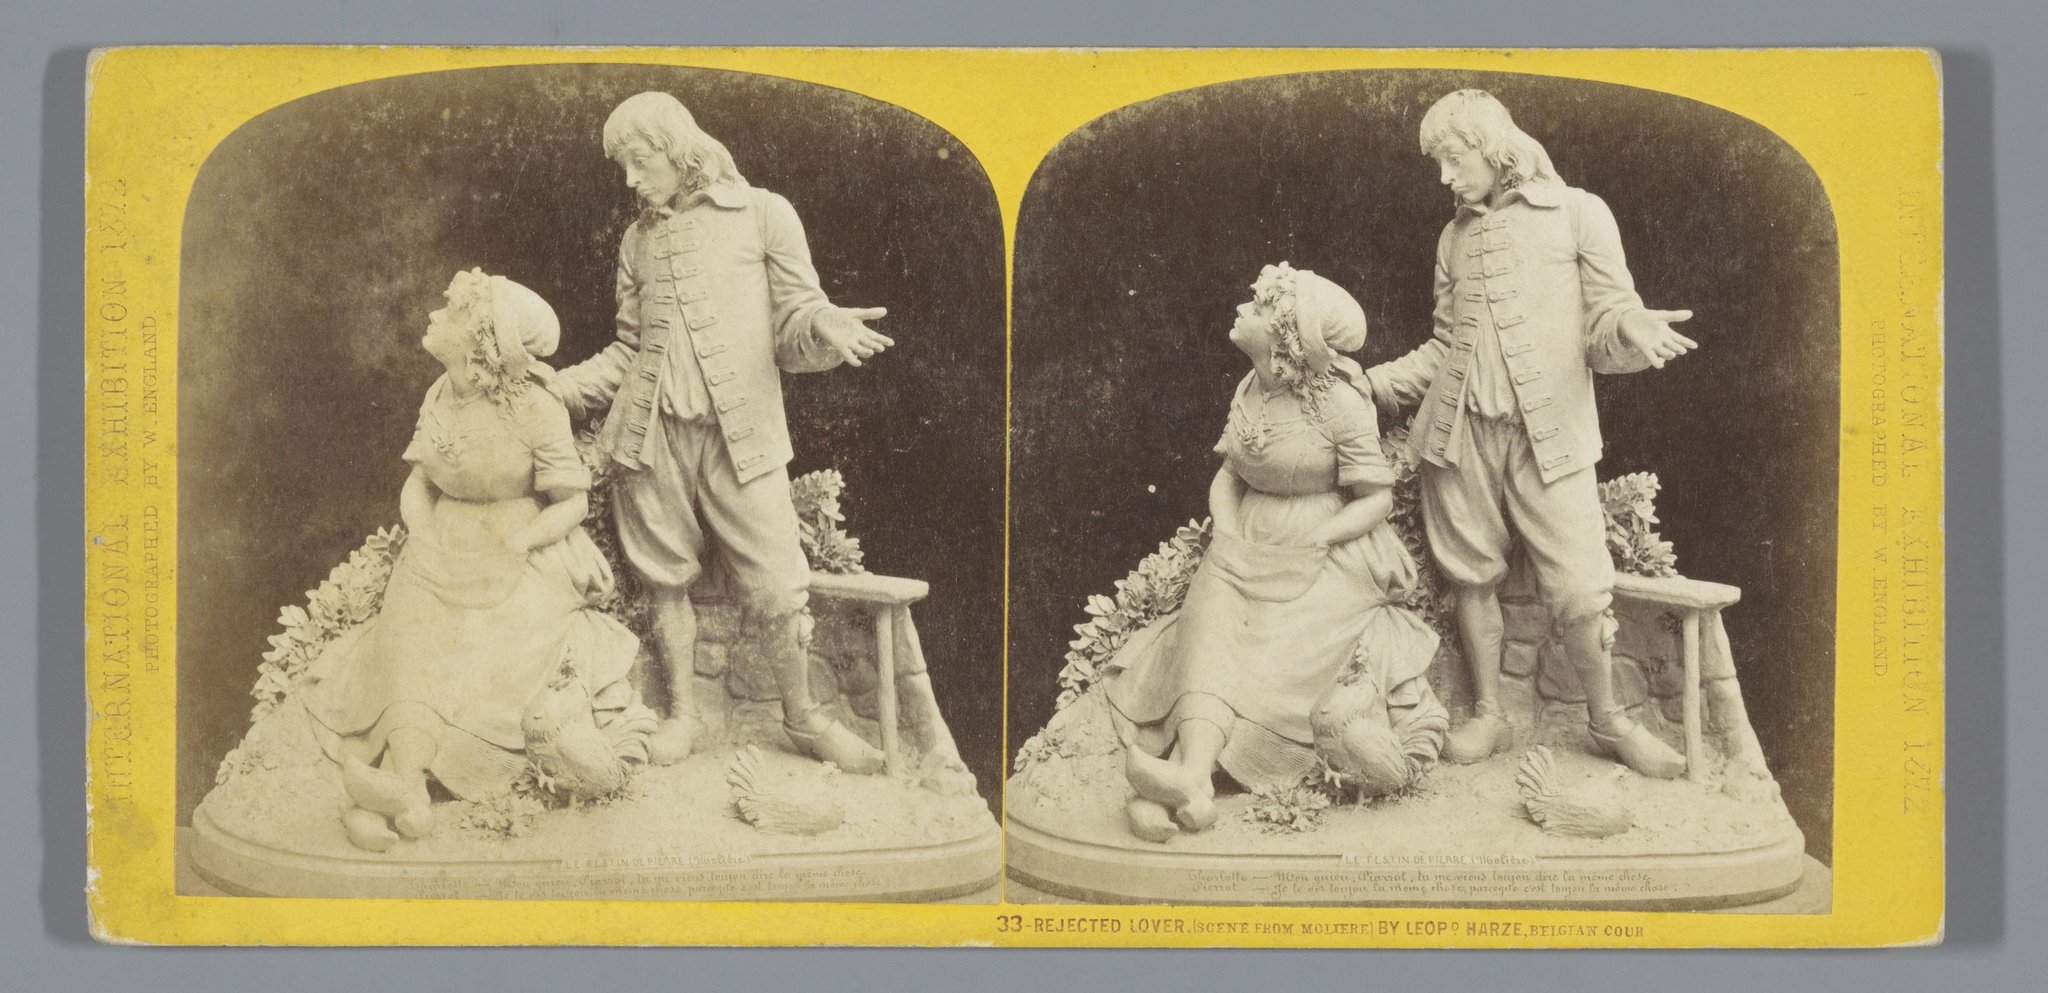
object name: stereograph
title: Sculptuur de Rejected Lover naar Leopold Harze op de Wereldtentoonstelling van 1872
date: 1872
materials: cardboard, paper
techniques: albumen print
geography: london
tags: world fair, world exhibition, sculpture, vienna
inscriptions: number: ‘33’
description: Verbeelding van een scène uit Dom Juan van Molière.